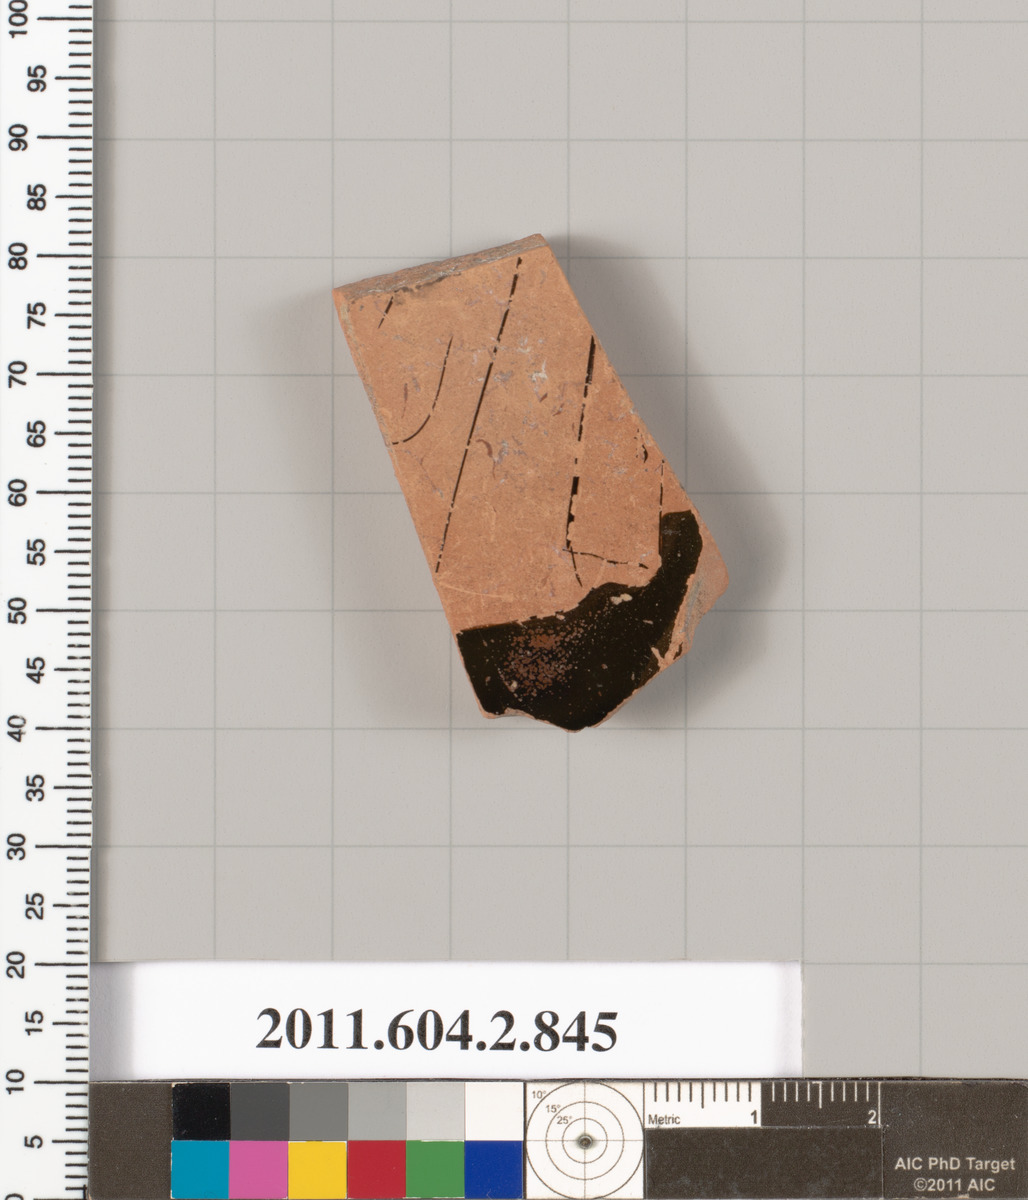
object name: bell krater fragment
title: Terracotta fragment of a bell-krater (bowl for mixing wine and water)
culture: greek, attic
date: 460-450 BCE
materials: terracotta